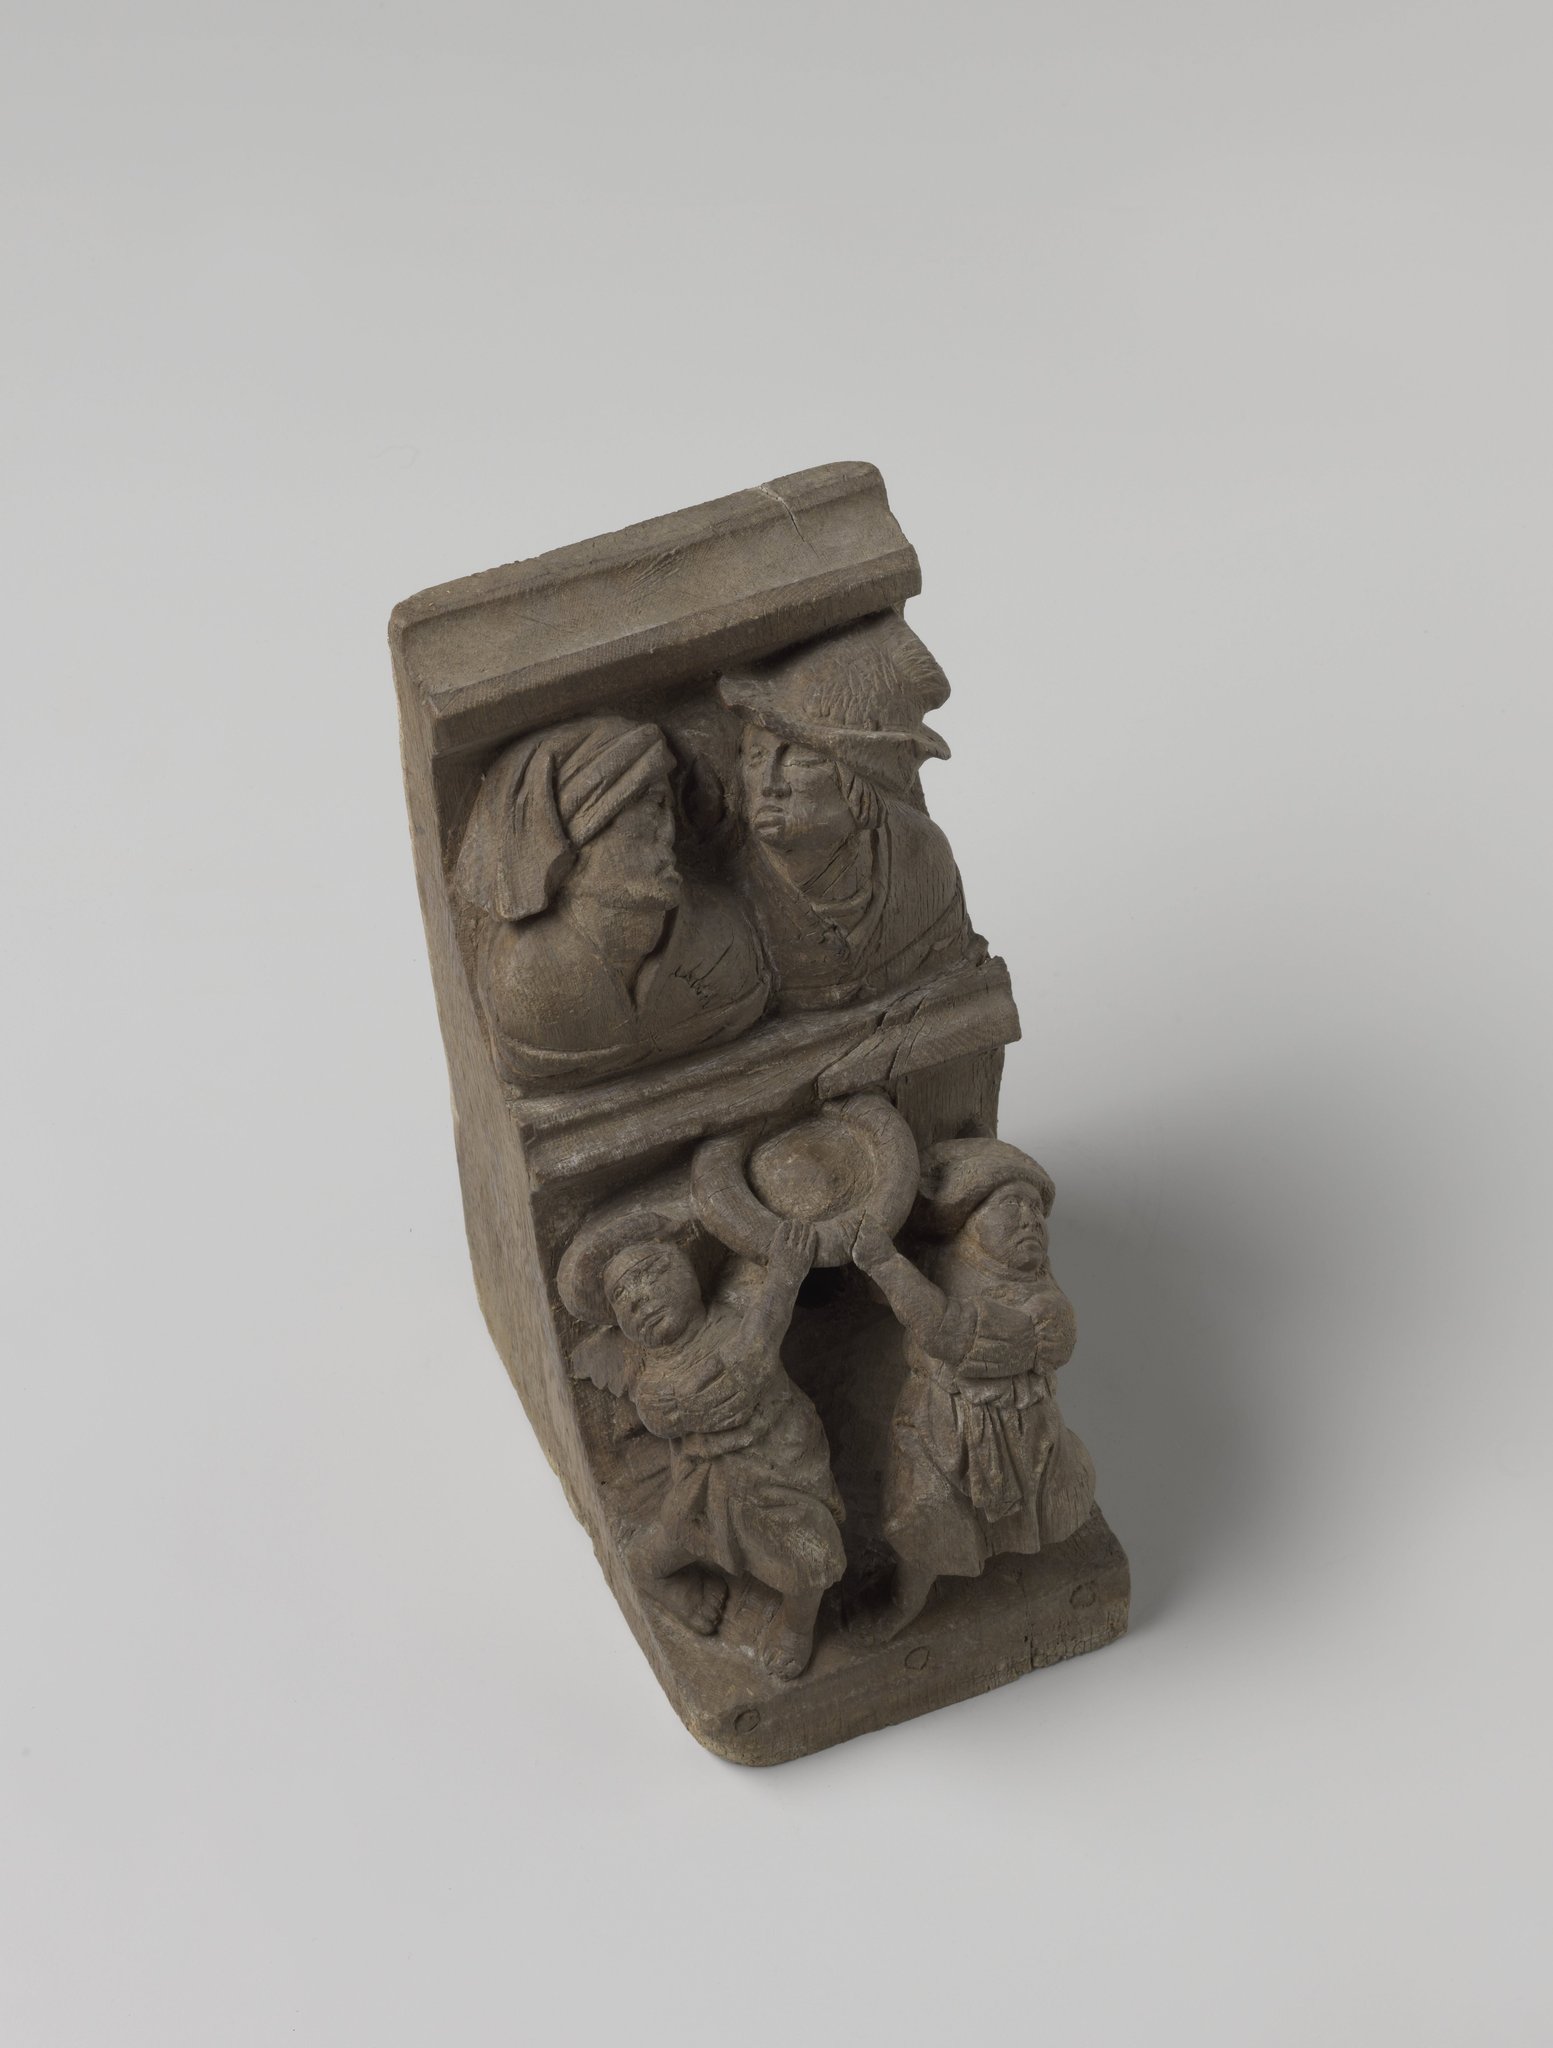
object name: balksleutel, sleutelstuk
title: Bouwfragment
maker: Anonymous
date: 1500-1600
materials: wood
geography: alkmaar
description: Balksleutel met snijwerk, die twee portretten en twee engelen die een krans vasthouden vertoont.